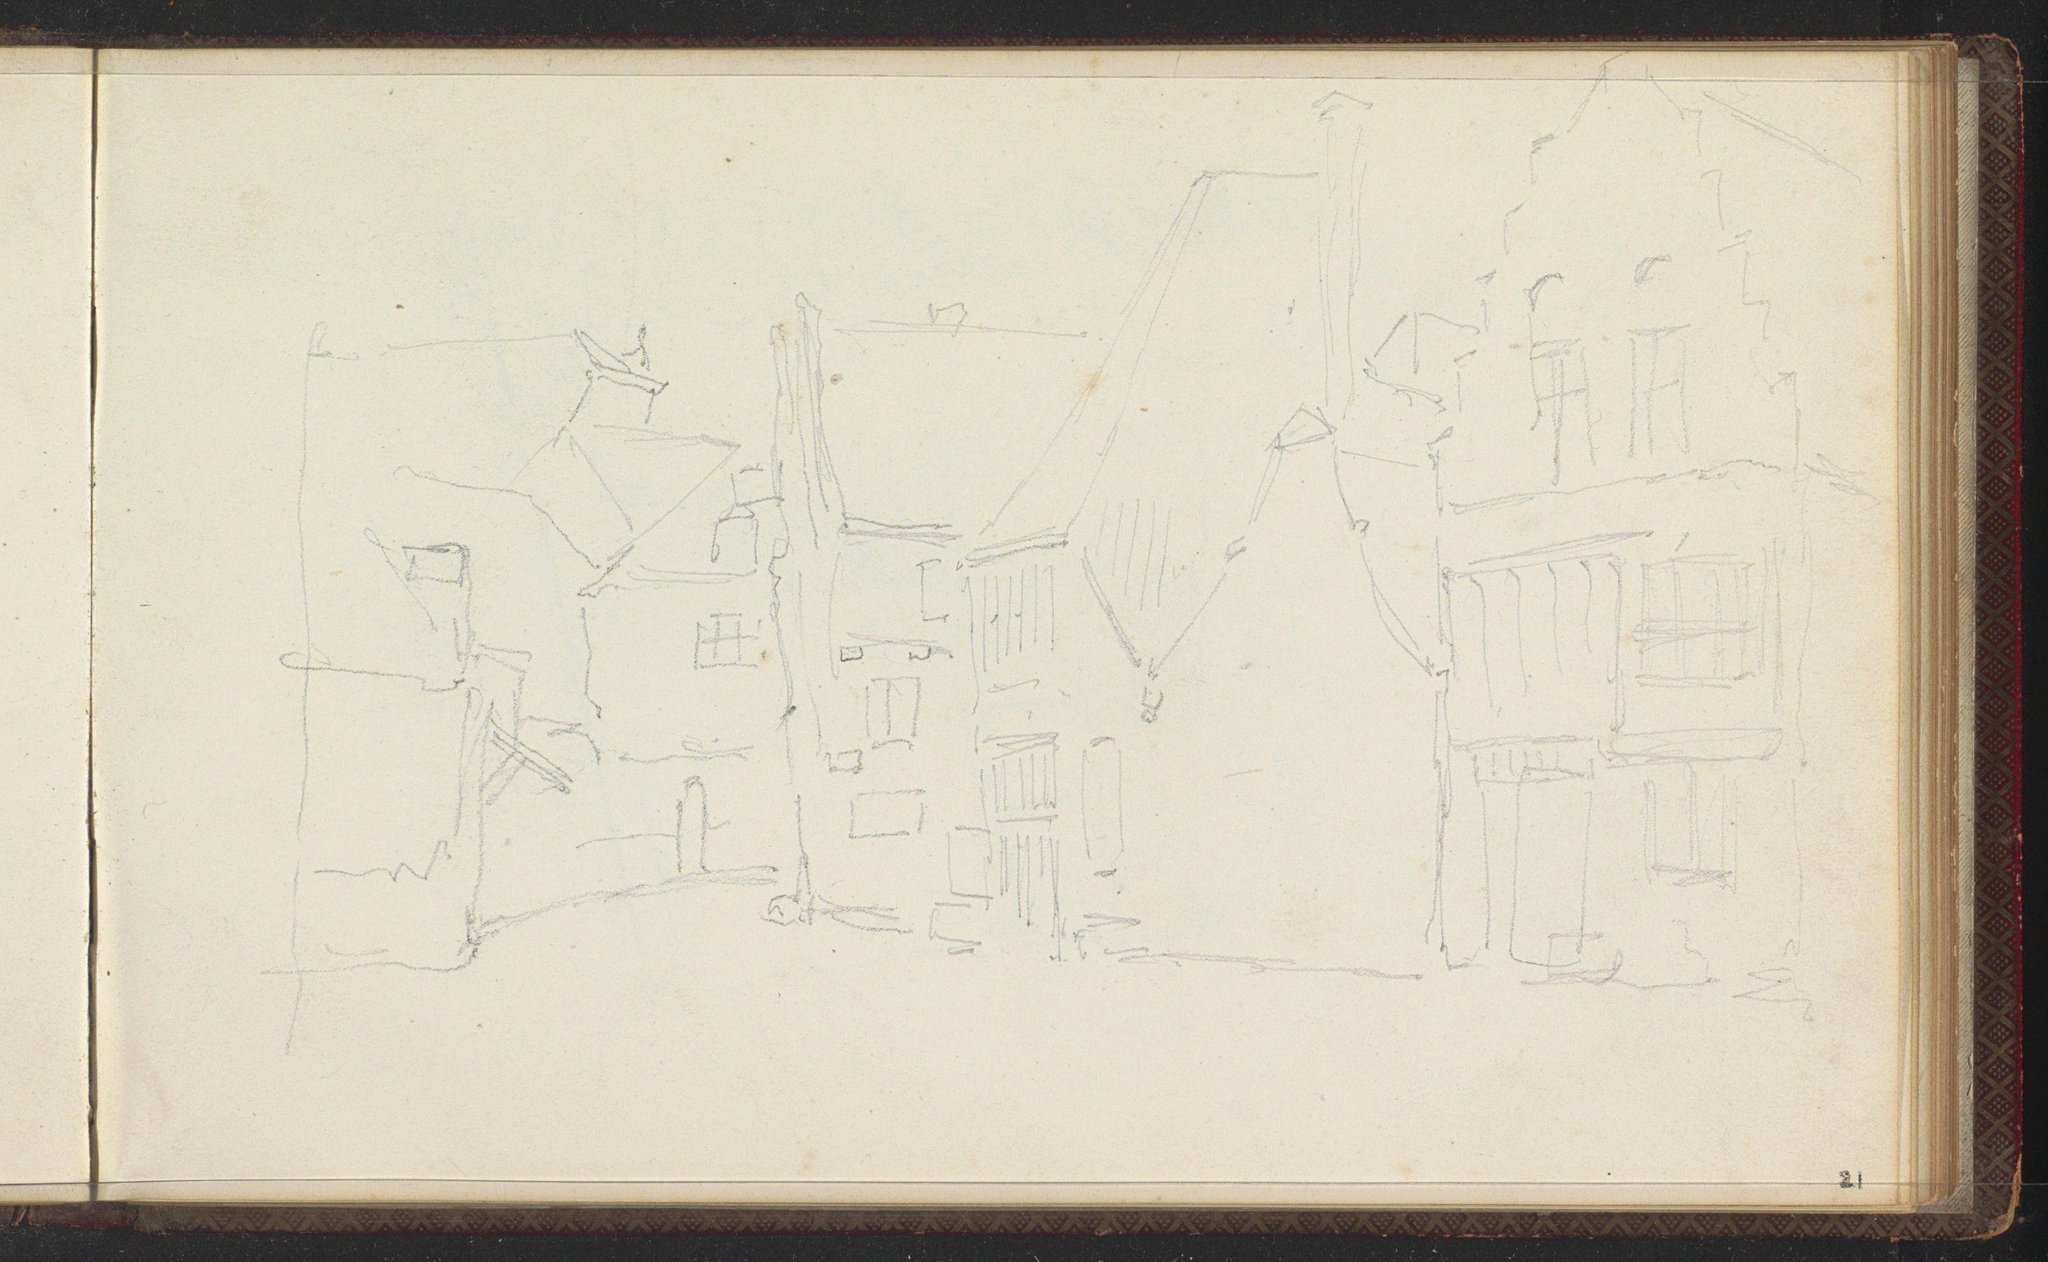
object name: sketchbook leaf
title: Gezicht op een straat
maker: adrianus eversen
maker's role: draughtsman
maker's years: 1818-1897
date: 1828-1897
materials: paper, pencil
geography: netherlands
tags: urban housing, street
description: Gezicht op een straat. Rechtsvoor een gebouw met een trapgevel. Blad 21 recto uit een schetsboek met 52 bladen vervaardigd in de omgeving van Kampen, Hattem, Hoorn en Zwolle.